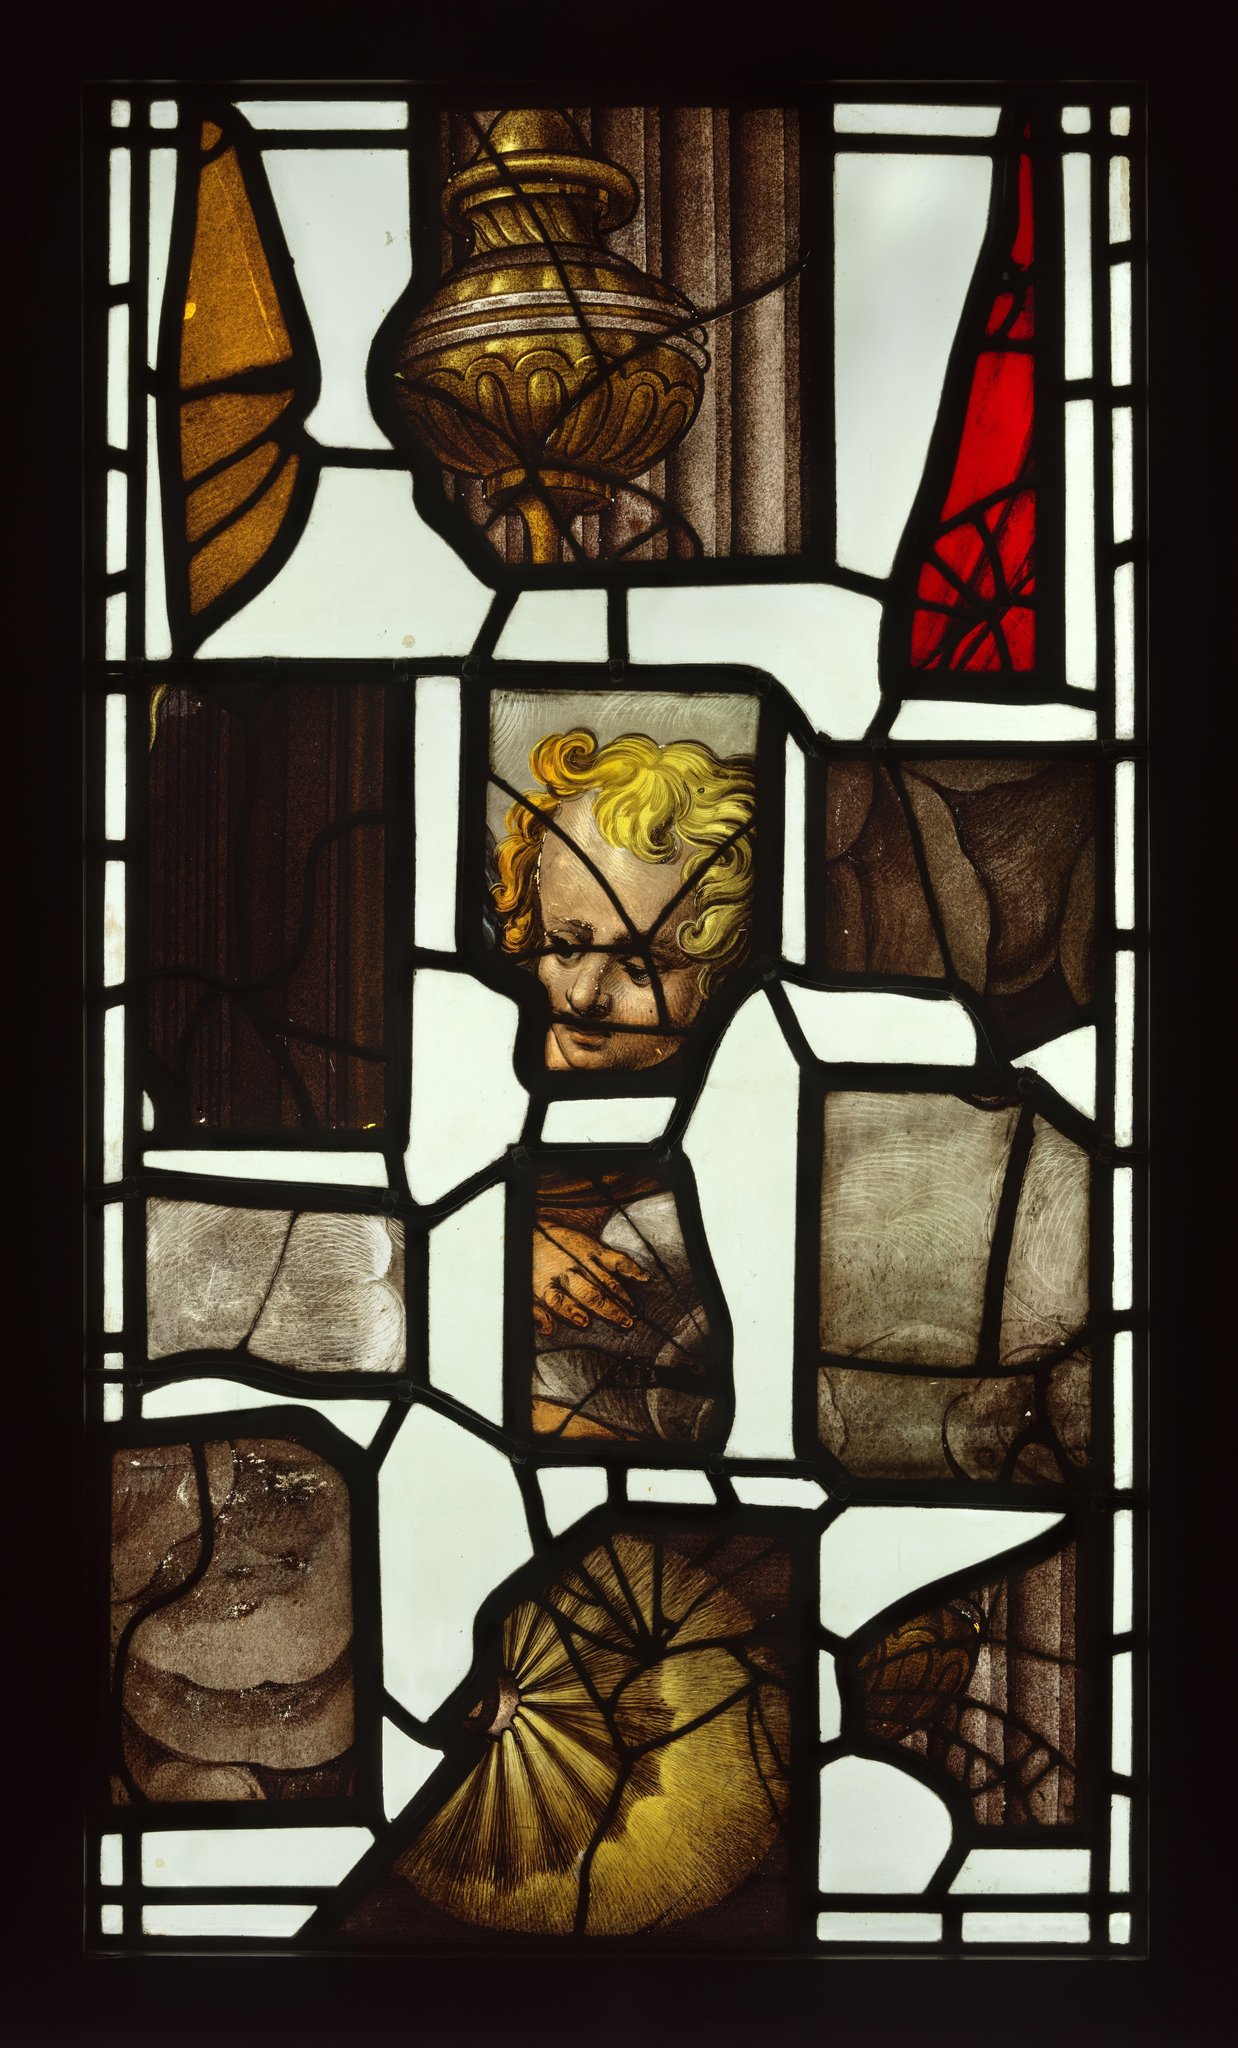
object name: light window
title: Ruit met 16e en 17e-eeuwse glasscherven afkomstig uit het raam van het Sterfbed van Maria in de Oude Kerk te Amsterdam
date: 1555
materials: glass, lead, pigment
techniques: enamel painting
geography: amsterdam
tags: oude kerk